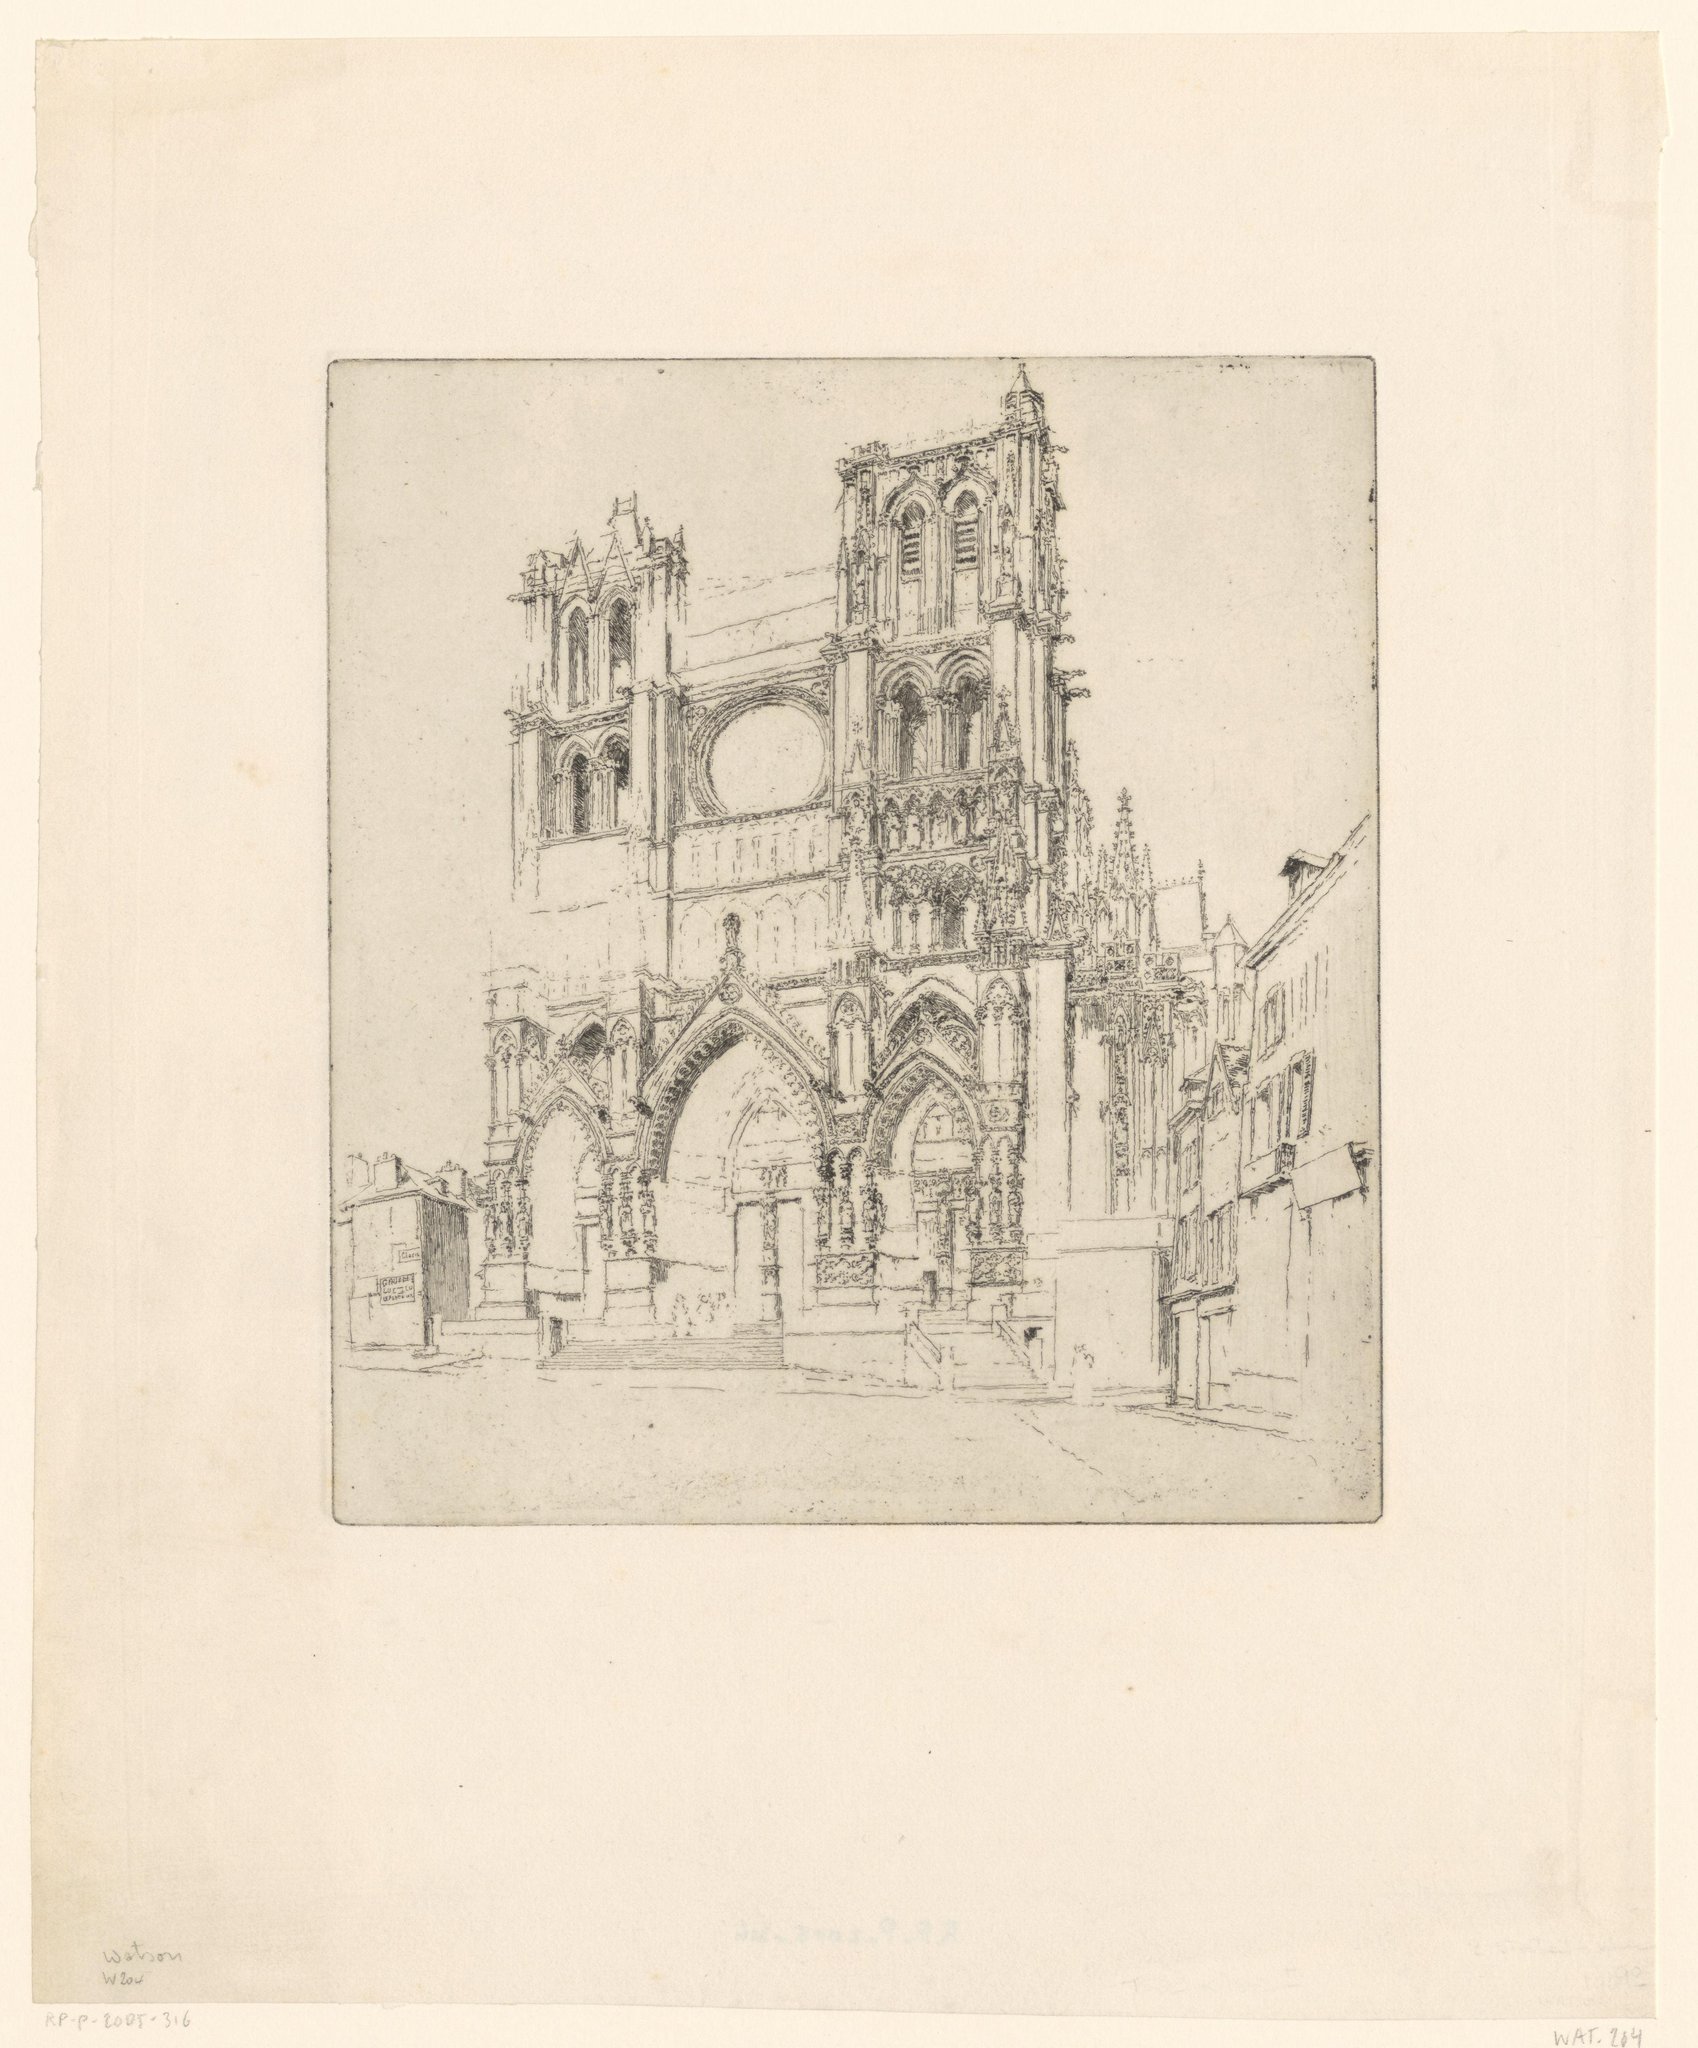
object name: print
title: Gezicht op de façade van de Notre-Dame van Amiens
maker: charles john watson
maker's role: print maker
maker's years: 1846-1927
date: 1875-1926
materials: paper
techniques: etching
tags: parts of church exterior and annexes: façade, notre-dame d'amiens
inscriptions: collector's mark: Lugt 2228, collector's mark: Lugt 2760